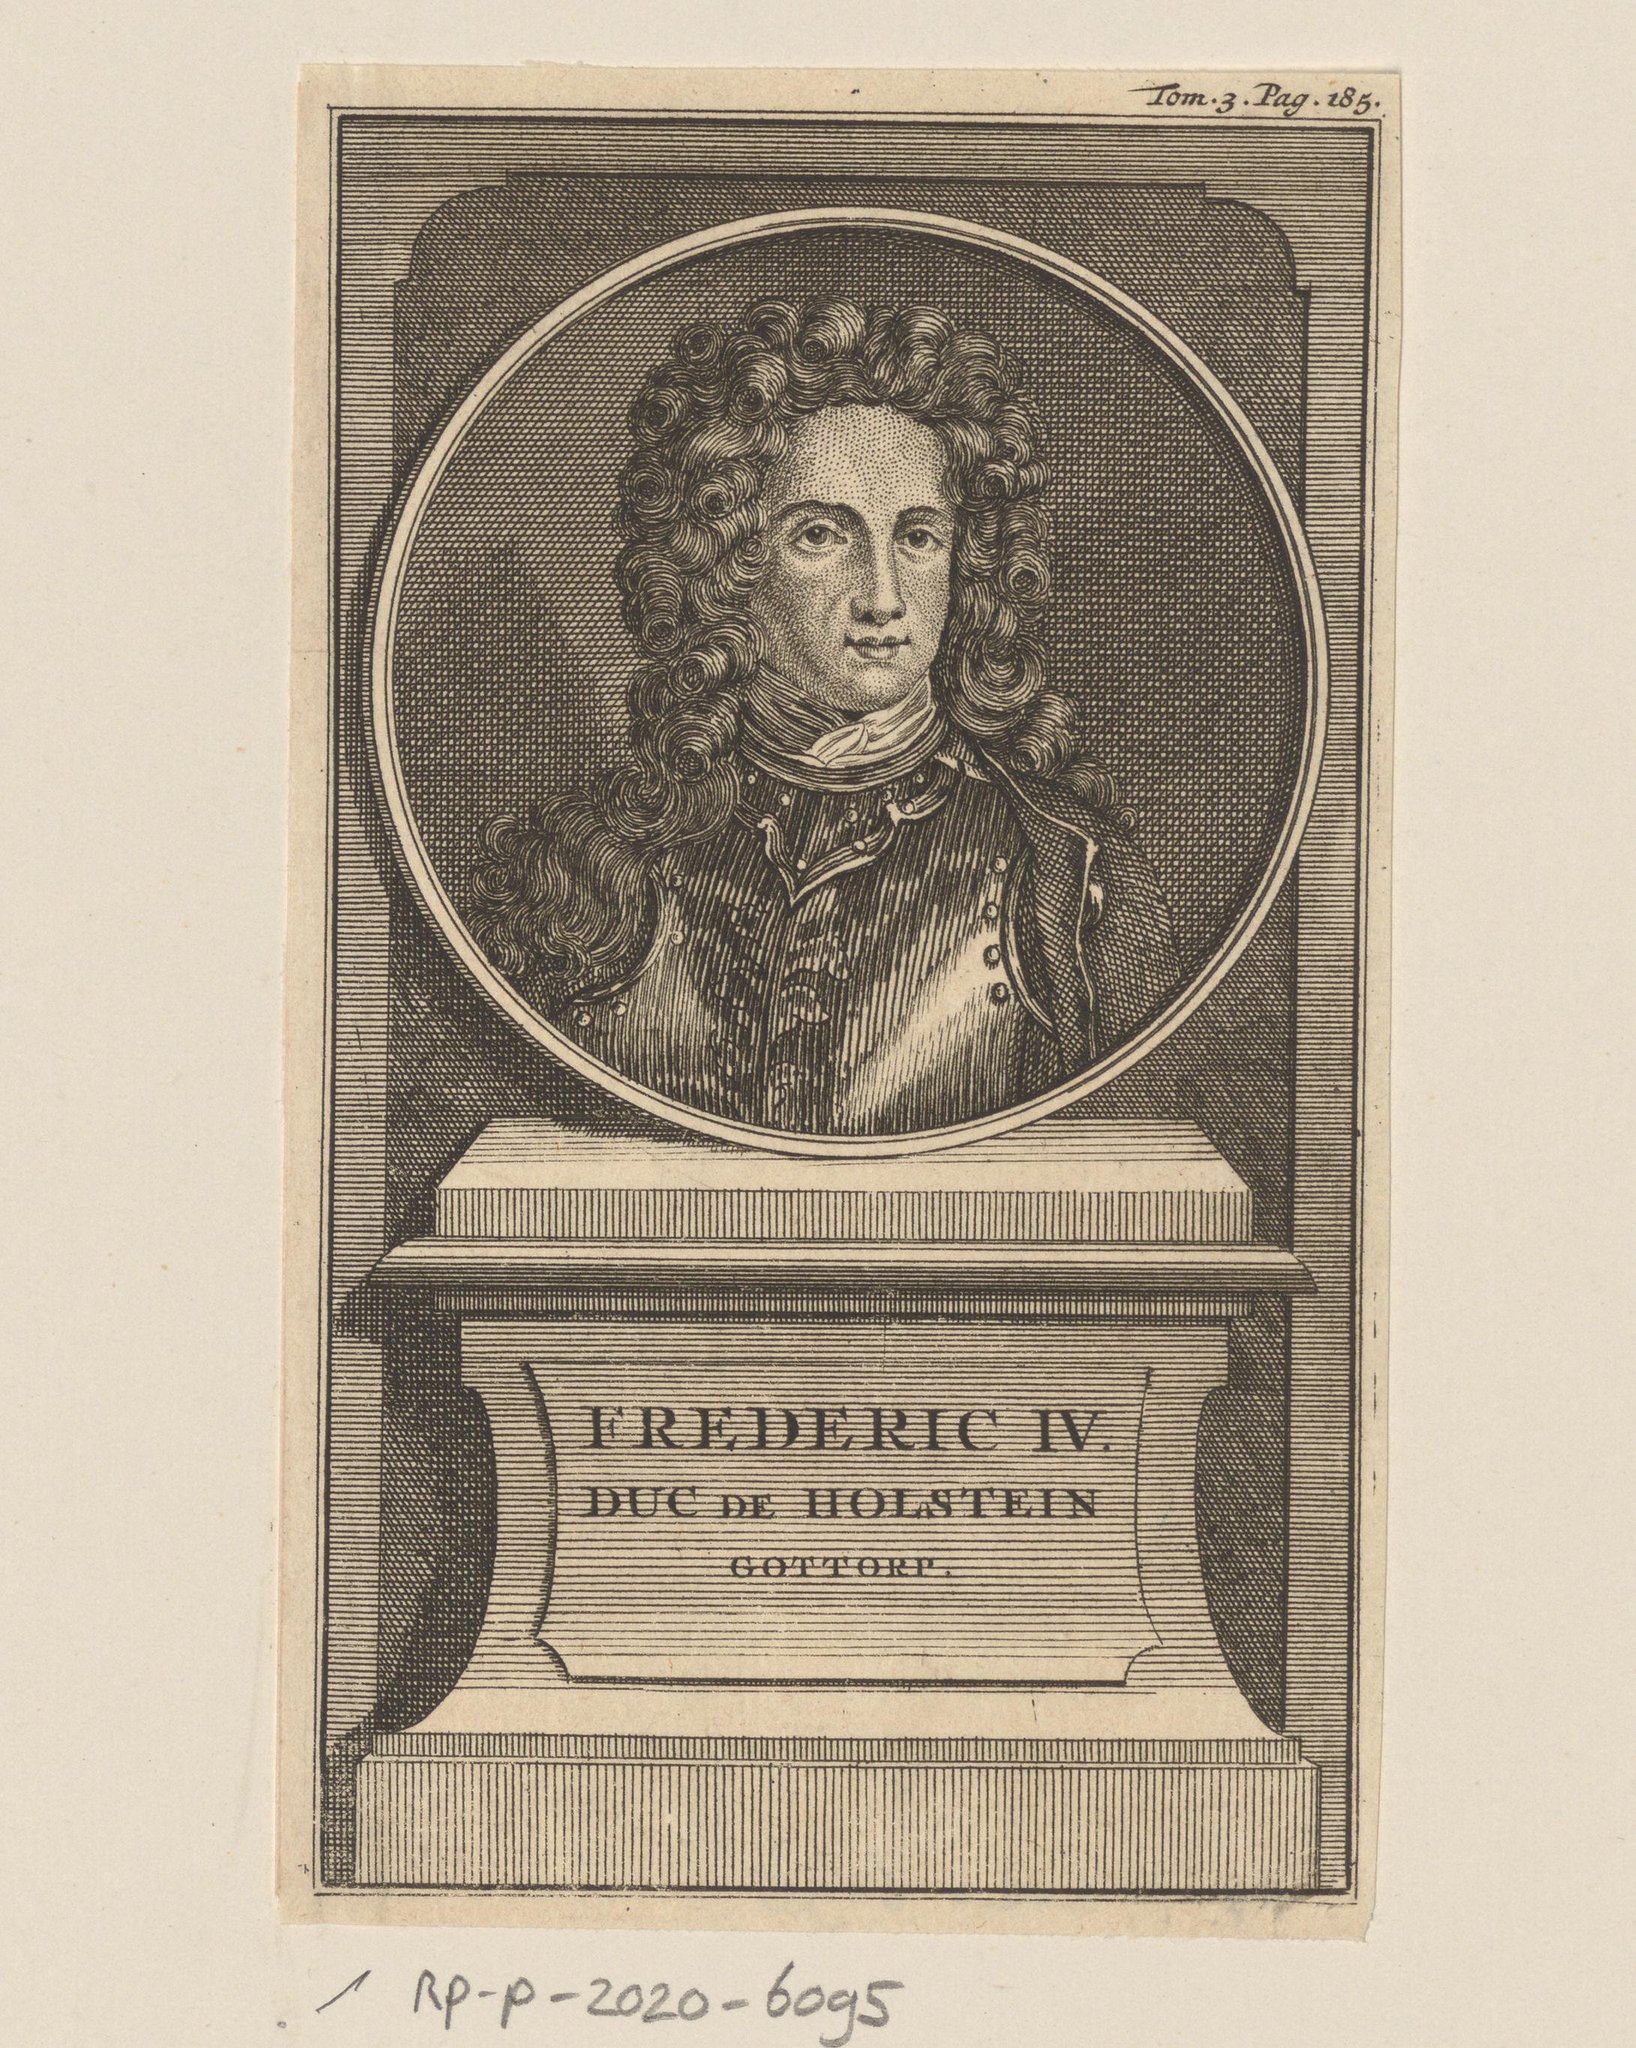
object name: book illustration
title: Portret van Frederik IV van Sleeswijk-Holstein-Gottorp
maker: Anonymous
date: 1700-1750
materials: paper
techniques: etching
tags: ornament ~ medallion, armour, historical persons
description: Prent komt waarschijnlijk uit een publicatie.